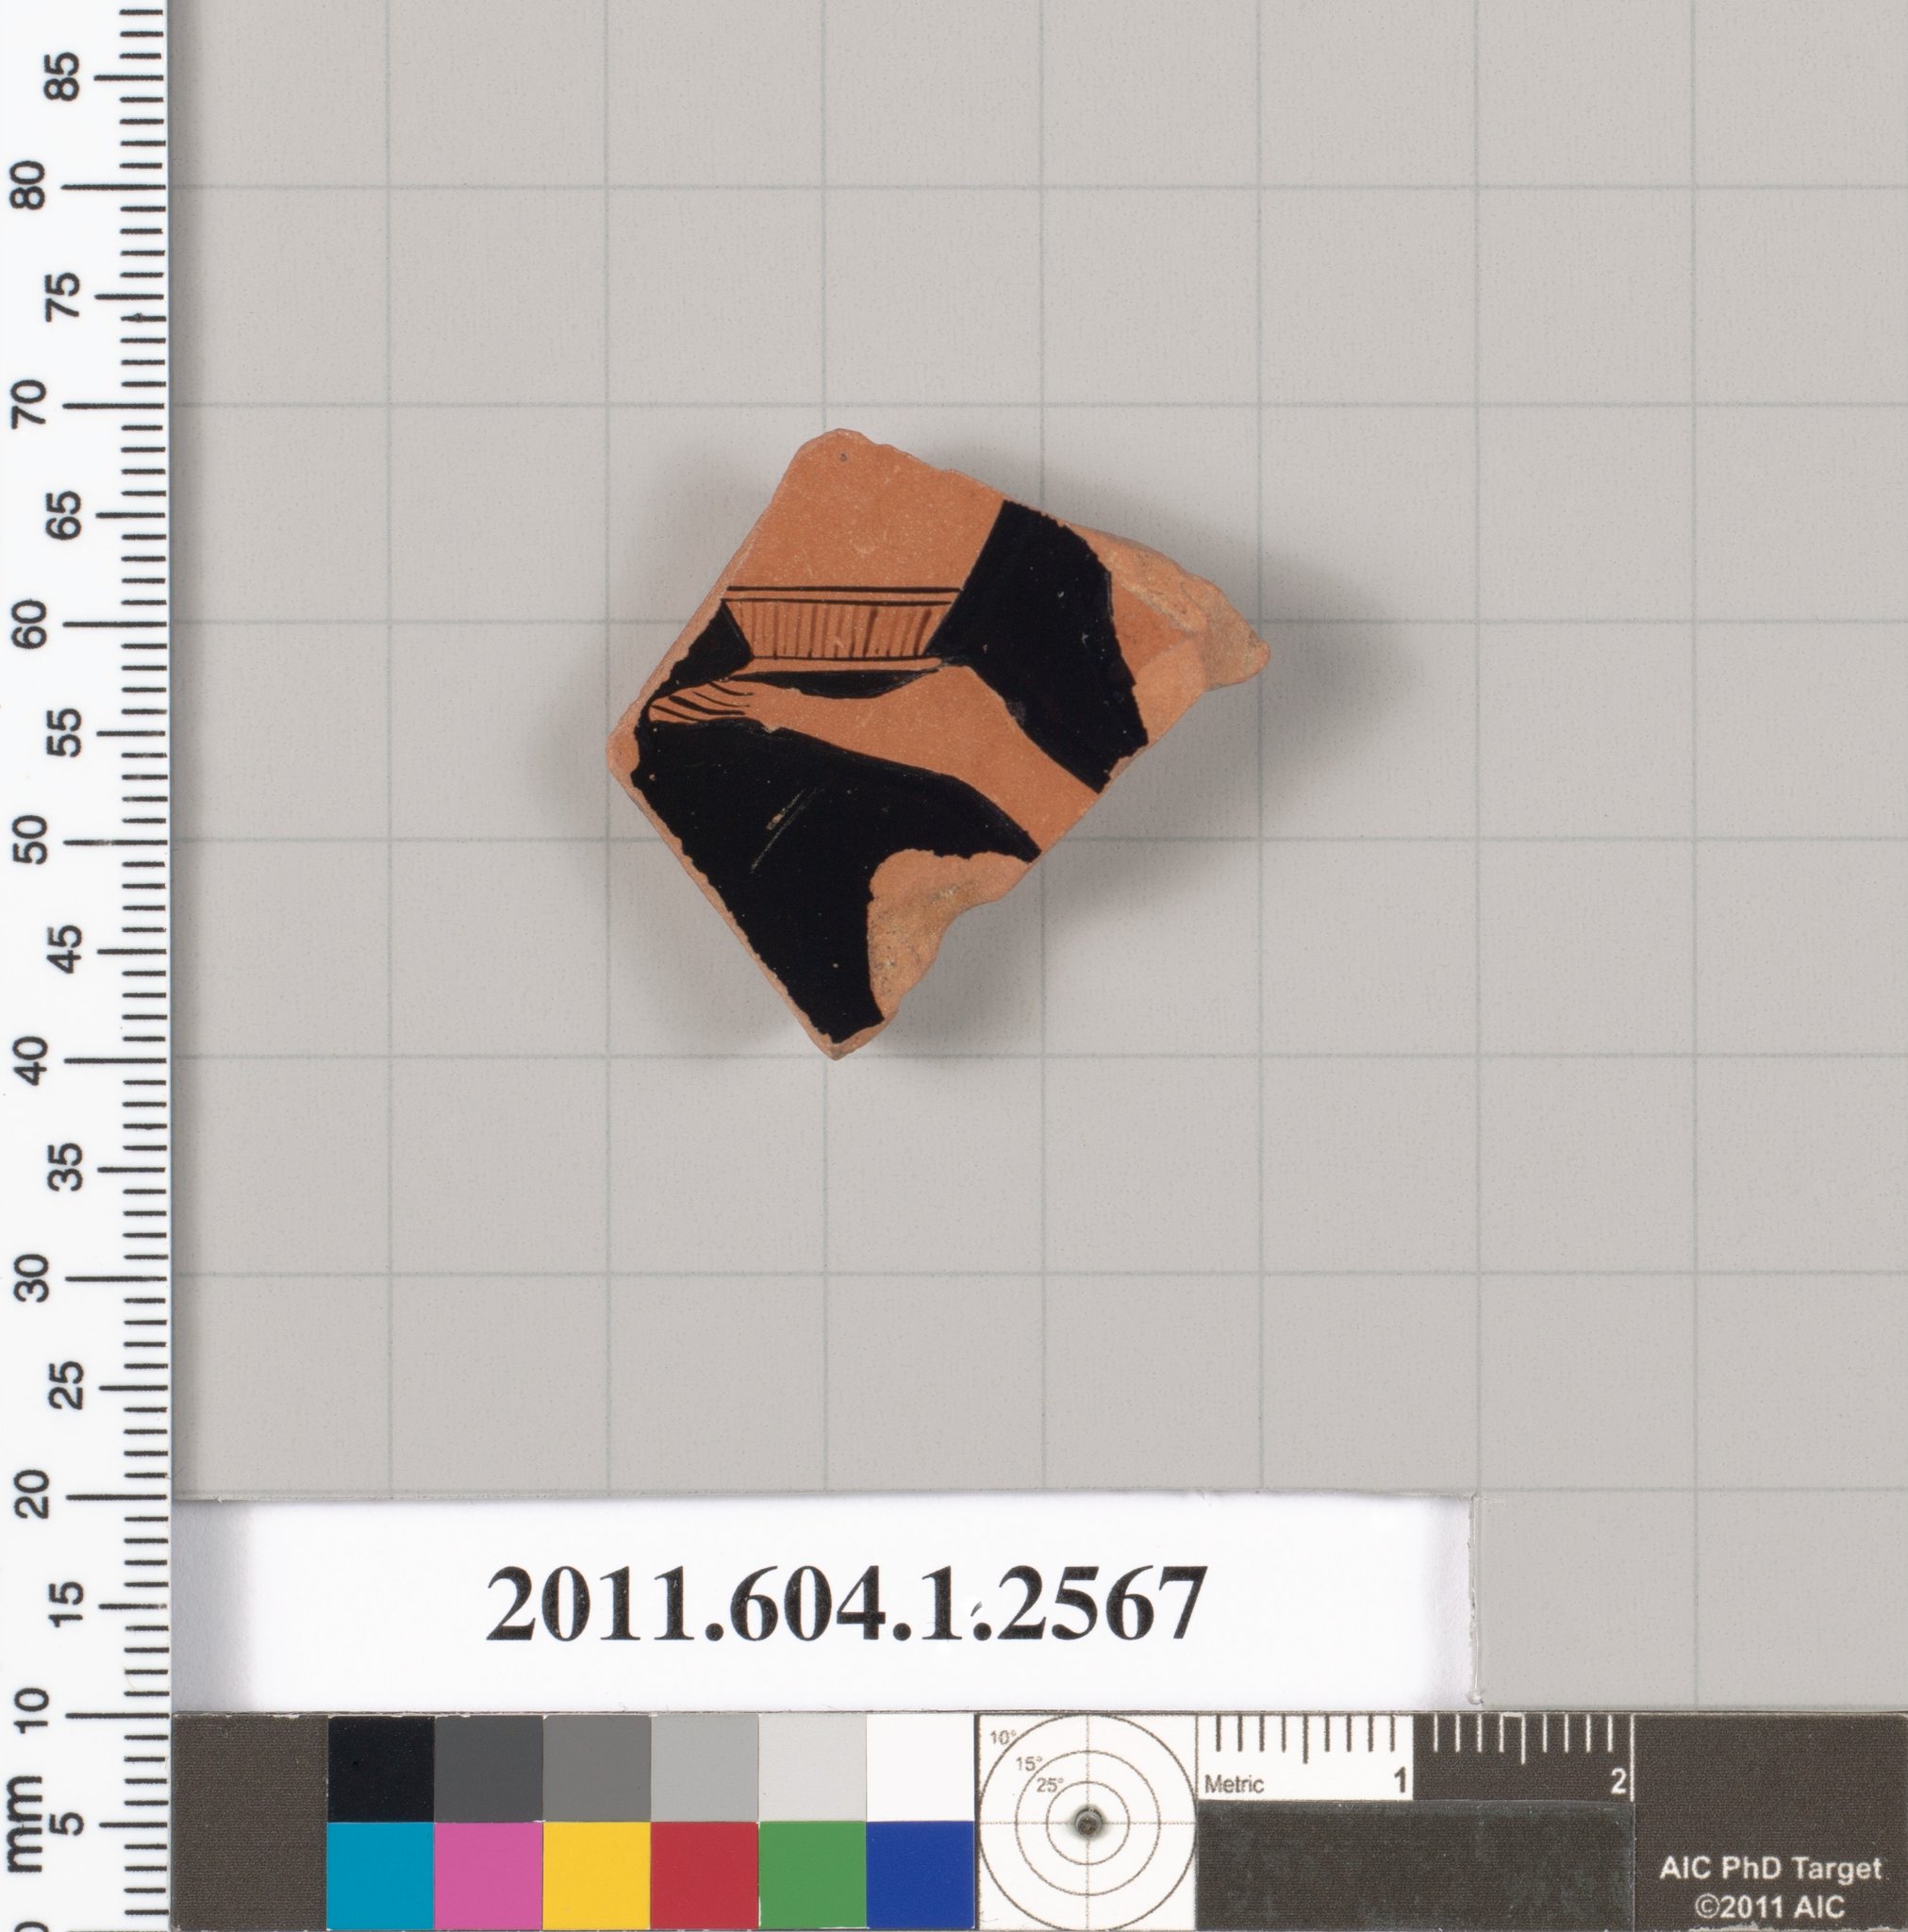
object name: kylix fragment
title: Terracotta fragment of a kylix (drinking cup)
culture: greek, attic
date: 490-480 BCE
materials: terracotta